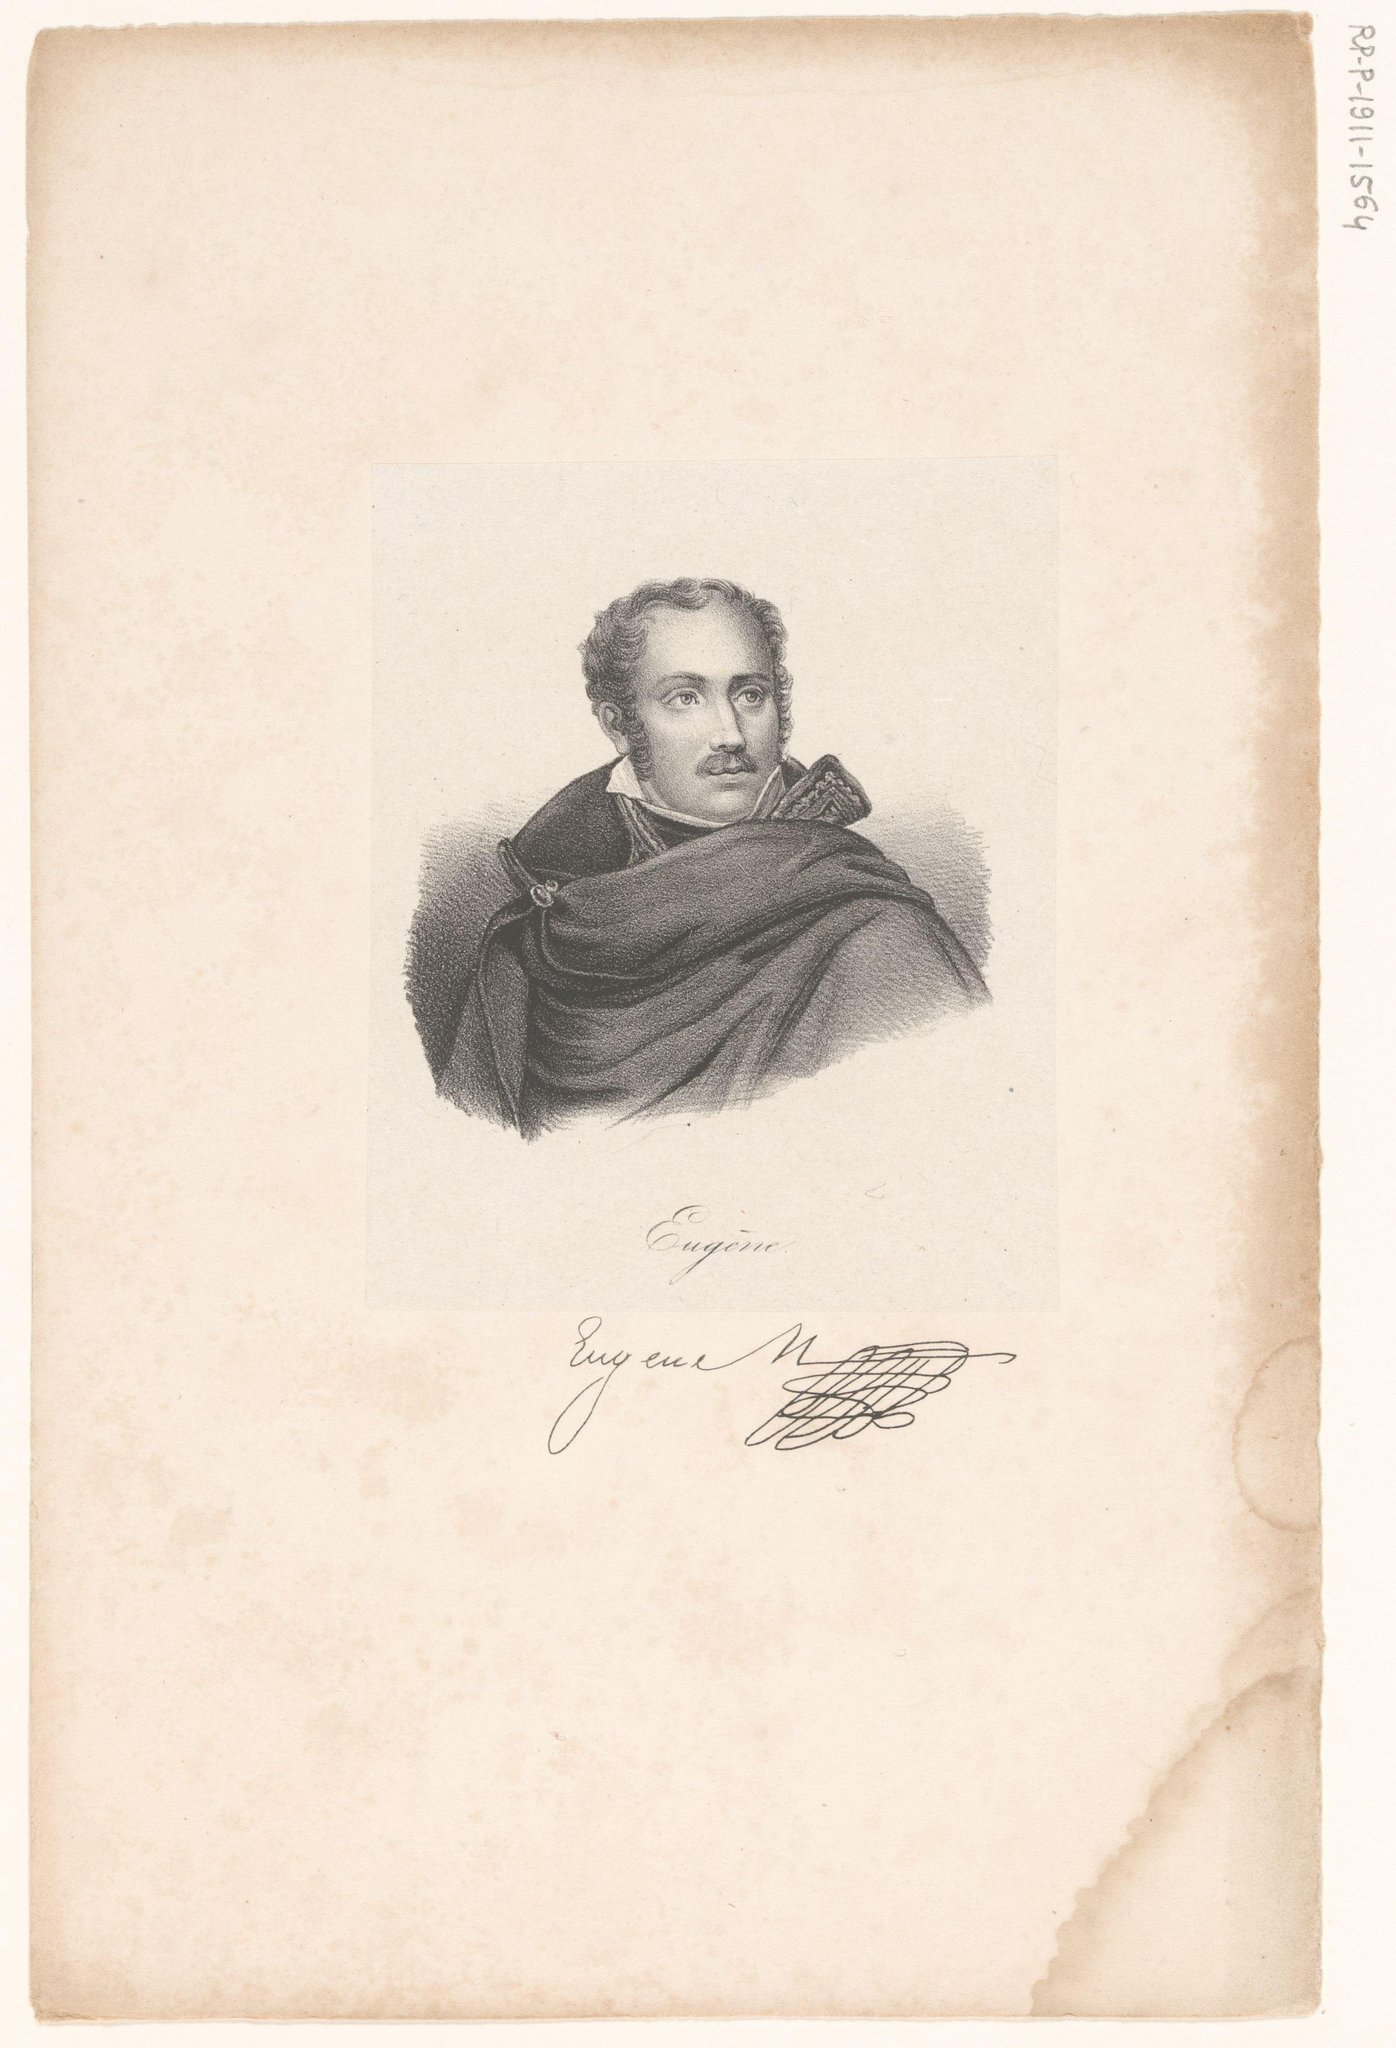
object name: print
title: Portret van Eugène de Beauharnais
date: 1818-1842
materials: paper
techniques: lithograph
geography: paris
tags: paris, eugène de beauharnais, historical persons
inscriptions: collector's mark: Lugt 2228a